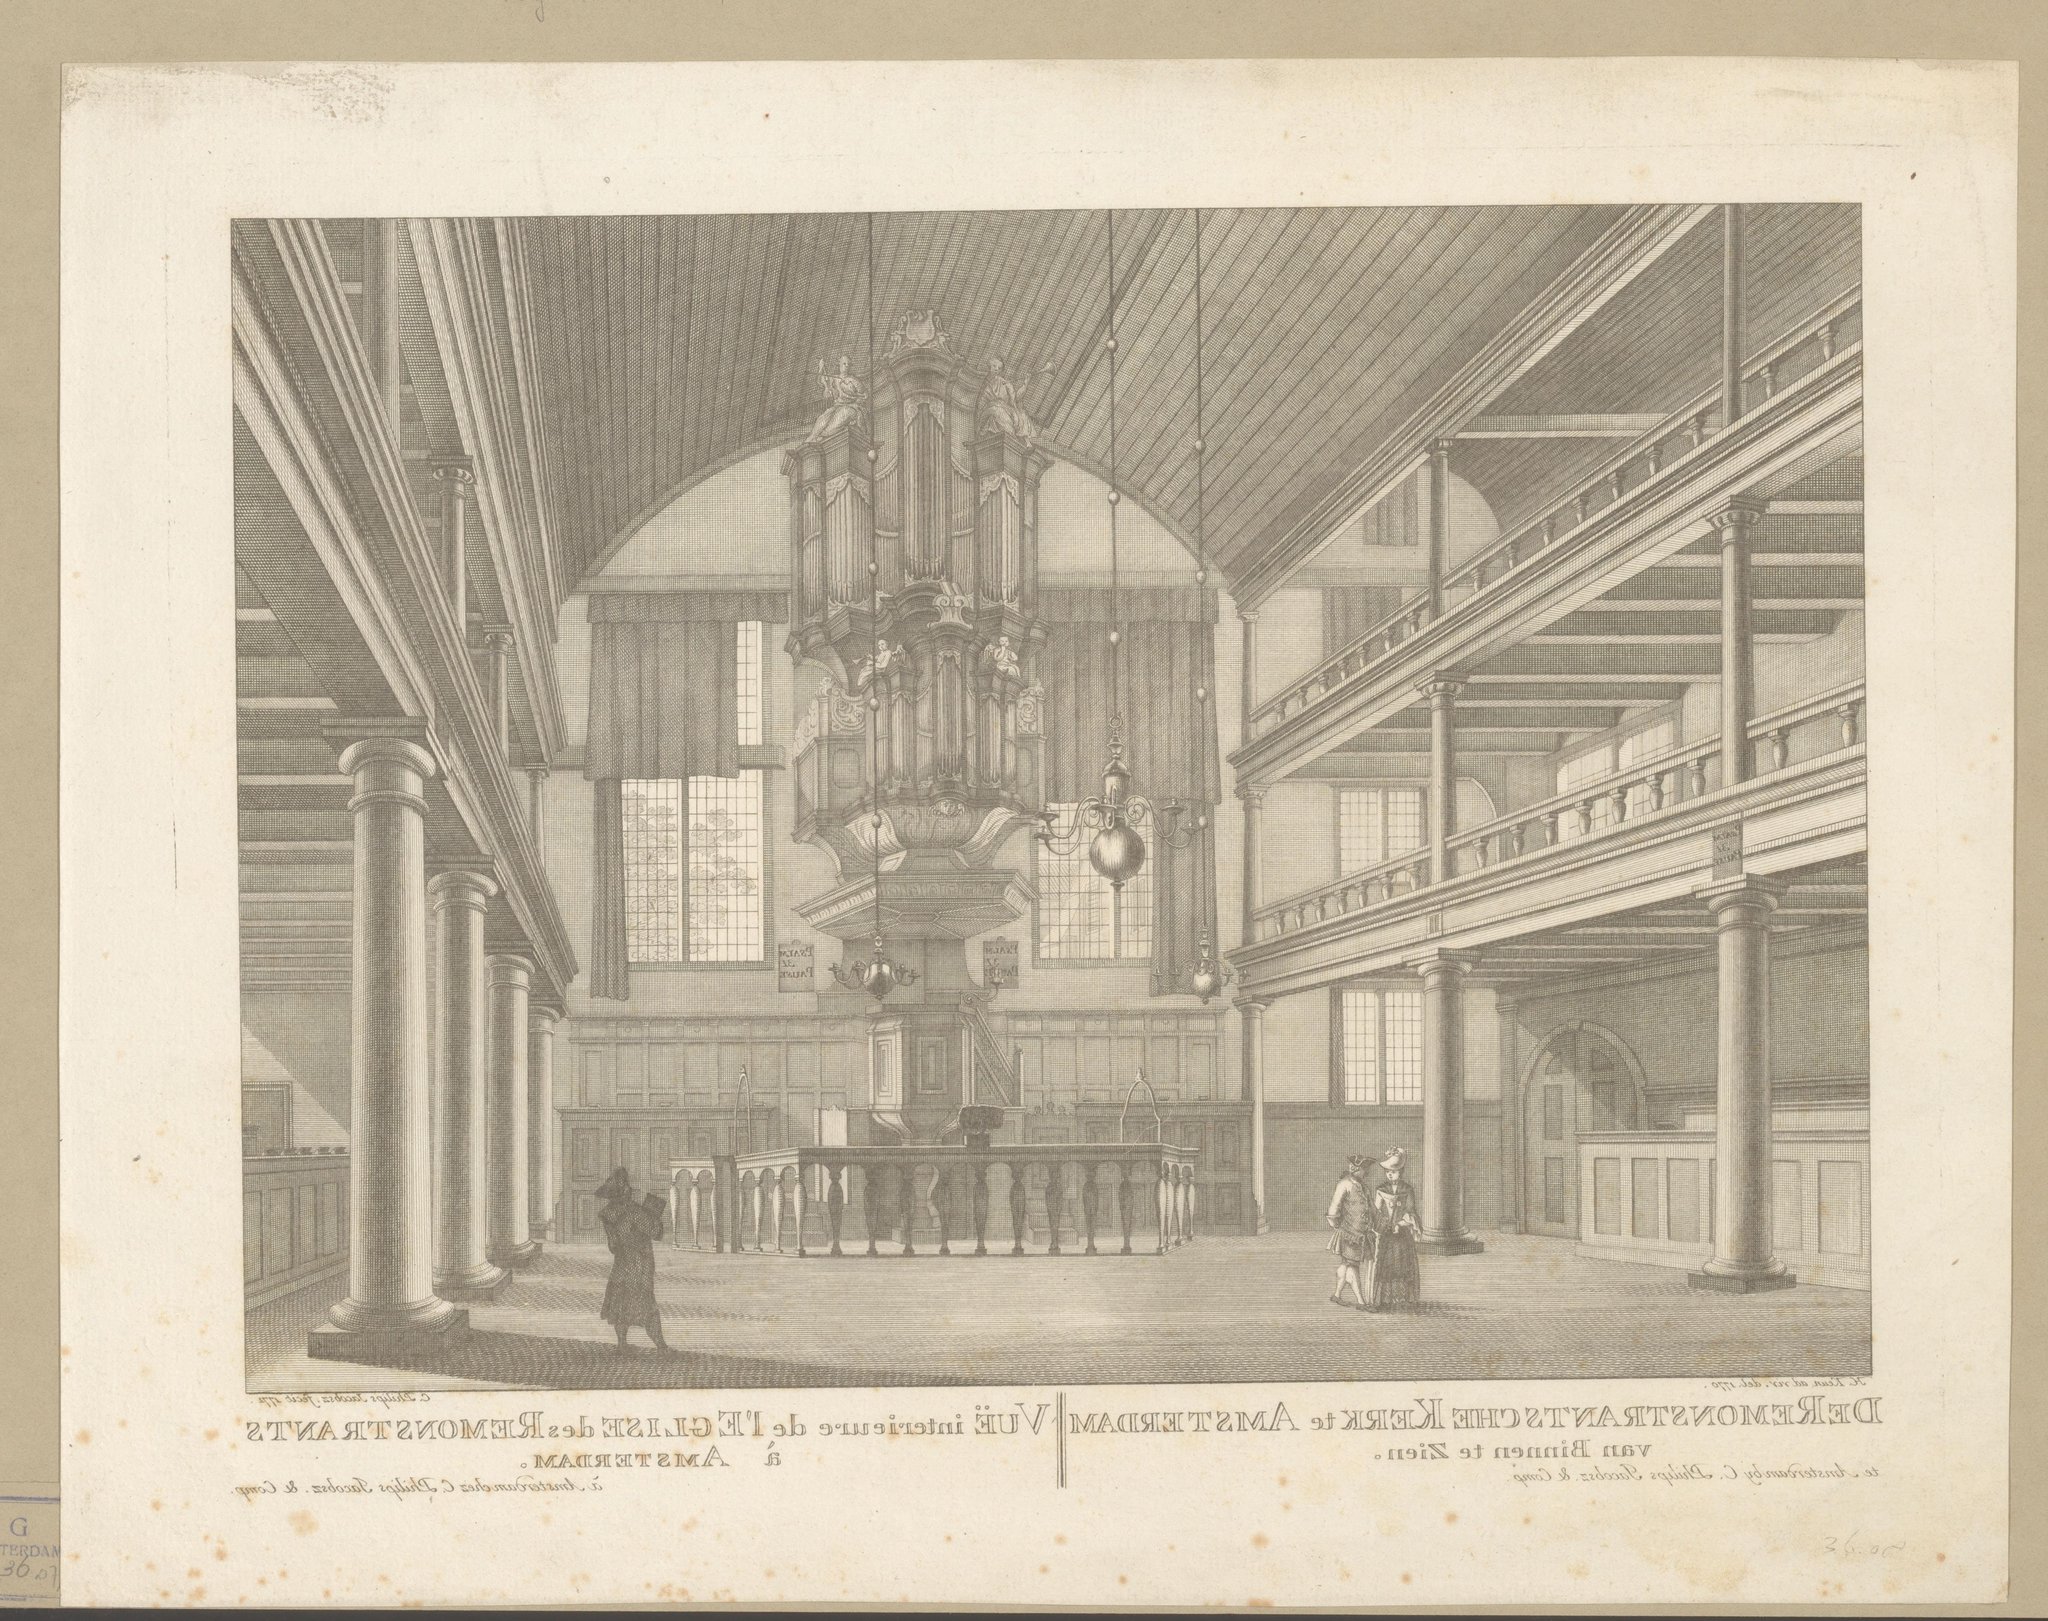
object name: print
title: De Remonstrantsche Kerk te Amsterdam van Binnen te Zien / Vuë interieure de l'Eglise des Remonstrants à Amsterdam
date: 1771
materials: paper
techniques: printmaking, engraving, etching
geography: amsterdam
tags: interior of church, amsterdam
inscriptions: collector's mark: Lugt 1641b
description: Onderwerpsrubriek binnen de Atlas Amsterdam: Kerkwezen: Remonstrantse Gemeente.